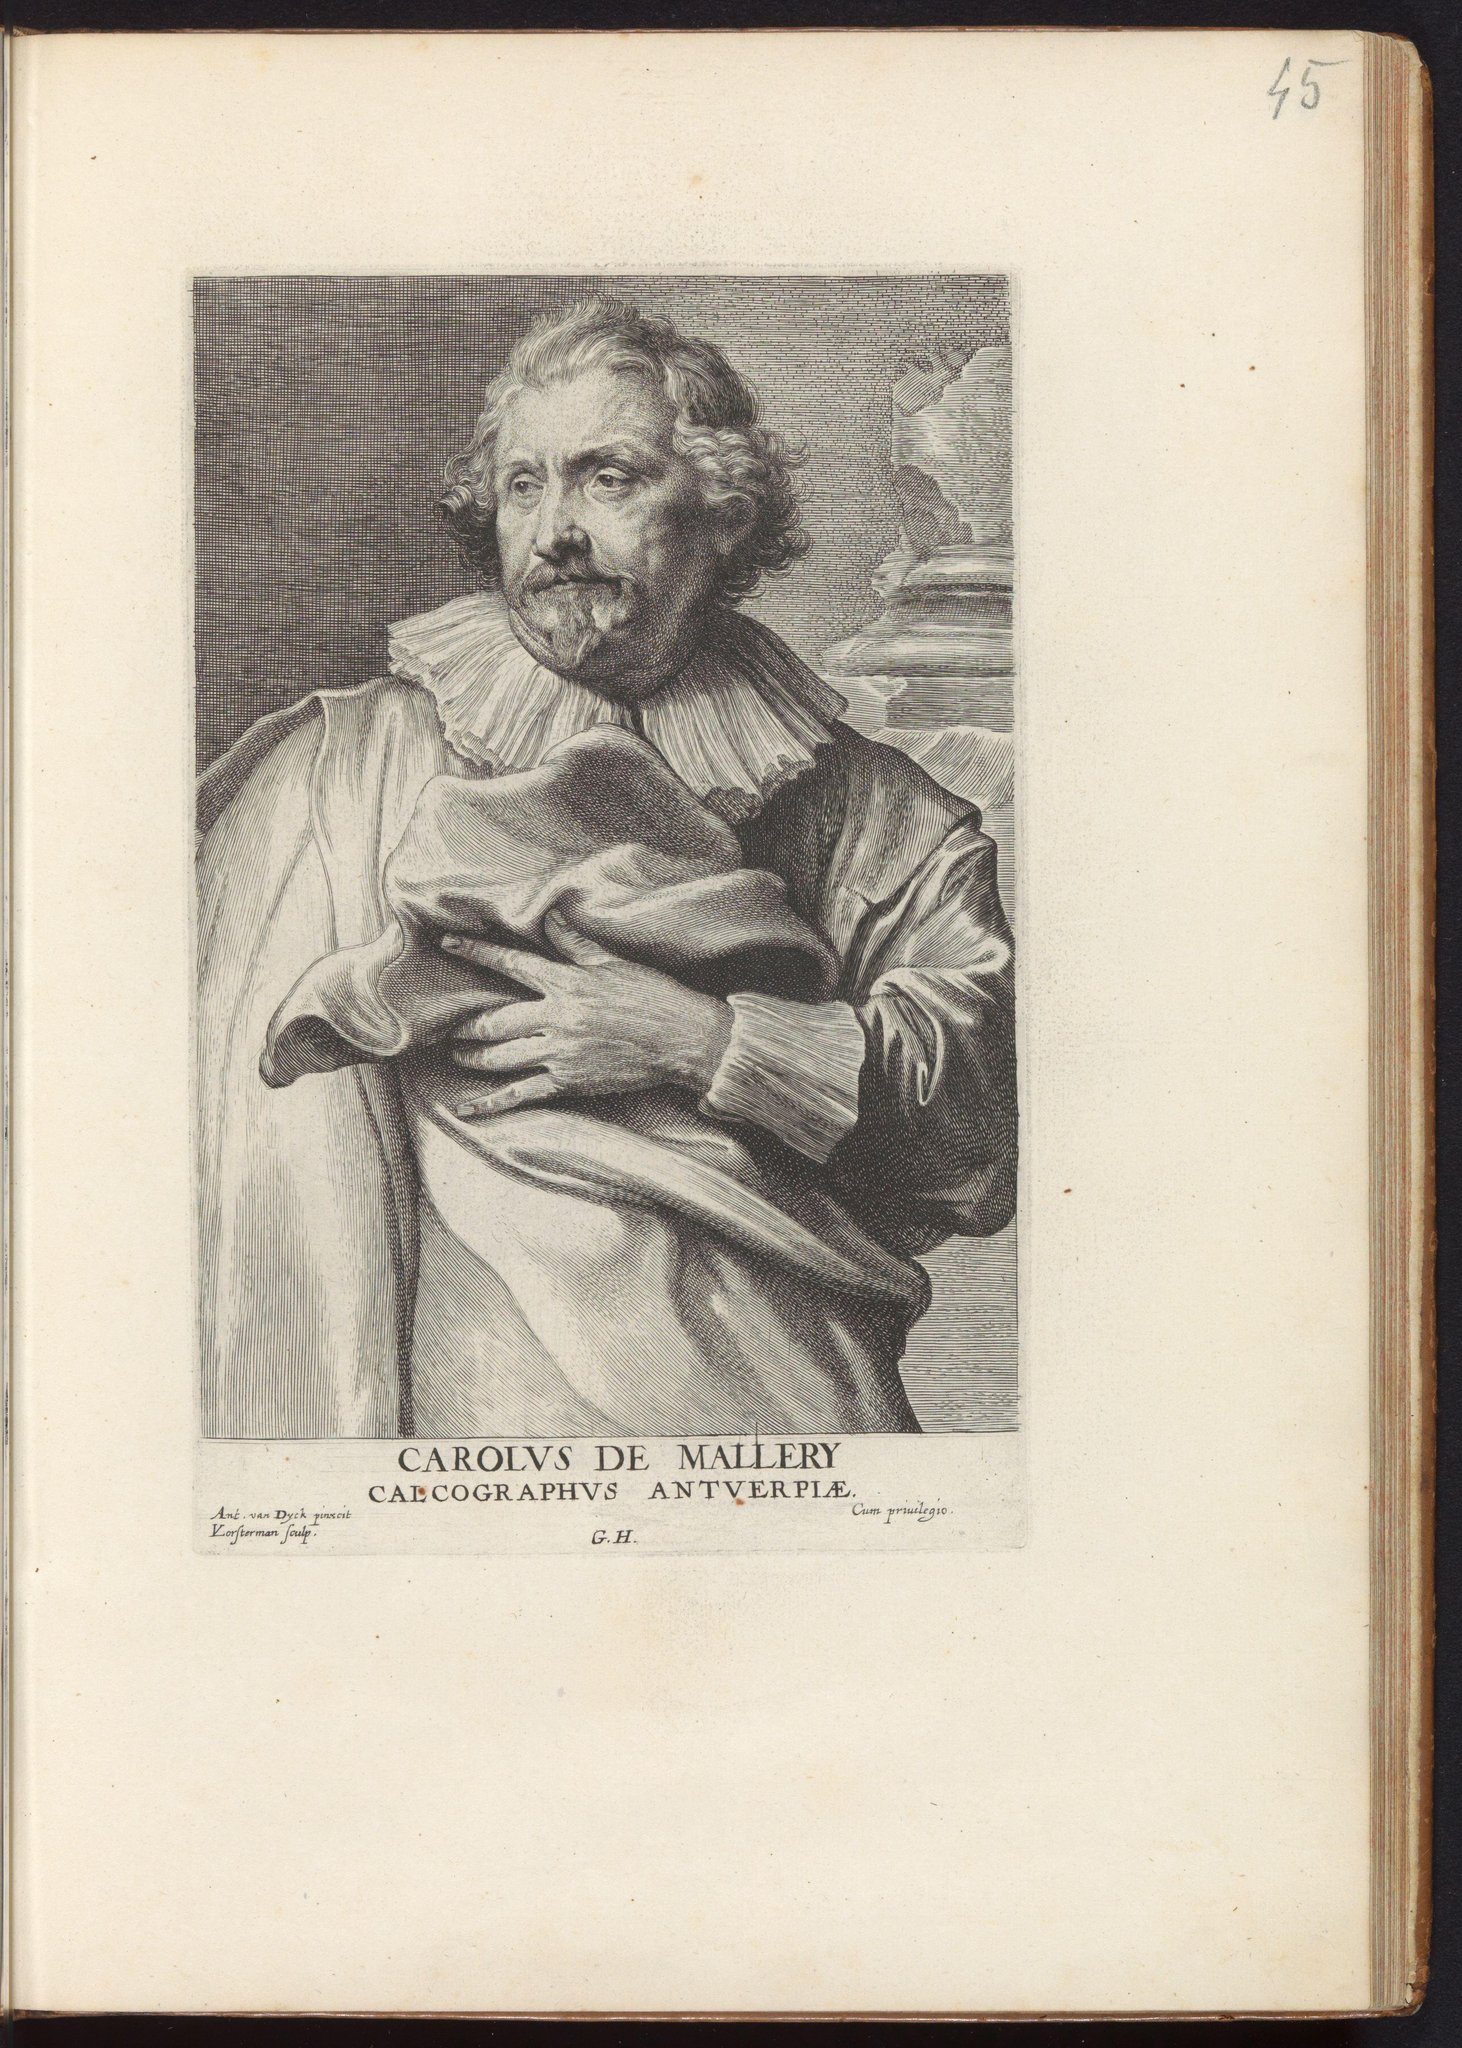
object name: print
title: Portret van Karel van Mallery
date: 1630-1641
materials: paper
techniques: engraving, etching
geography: antwerp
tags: antwerp, karel van mallery, portrait, self-portrait of graphic artist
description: Portret van de prentmaker, tekenaar en prenthandelaar Karel van Mallery. Deze prent maakt deel uit van een album.